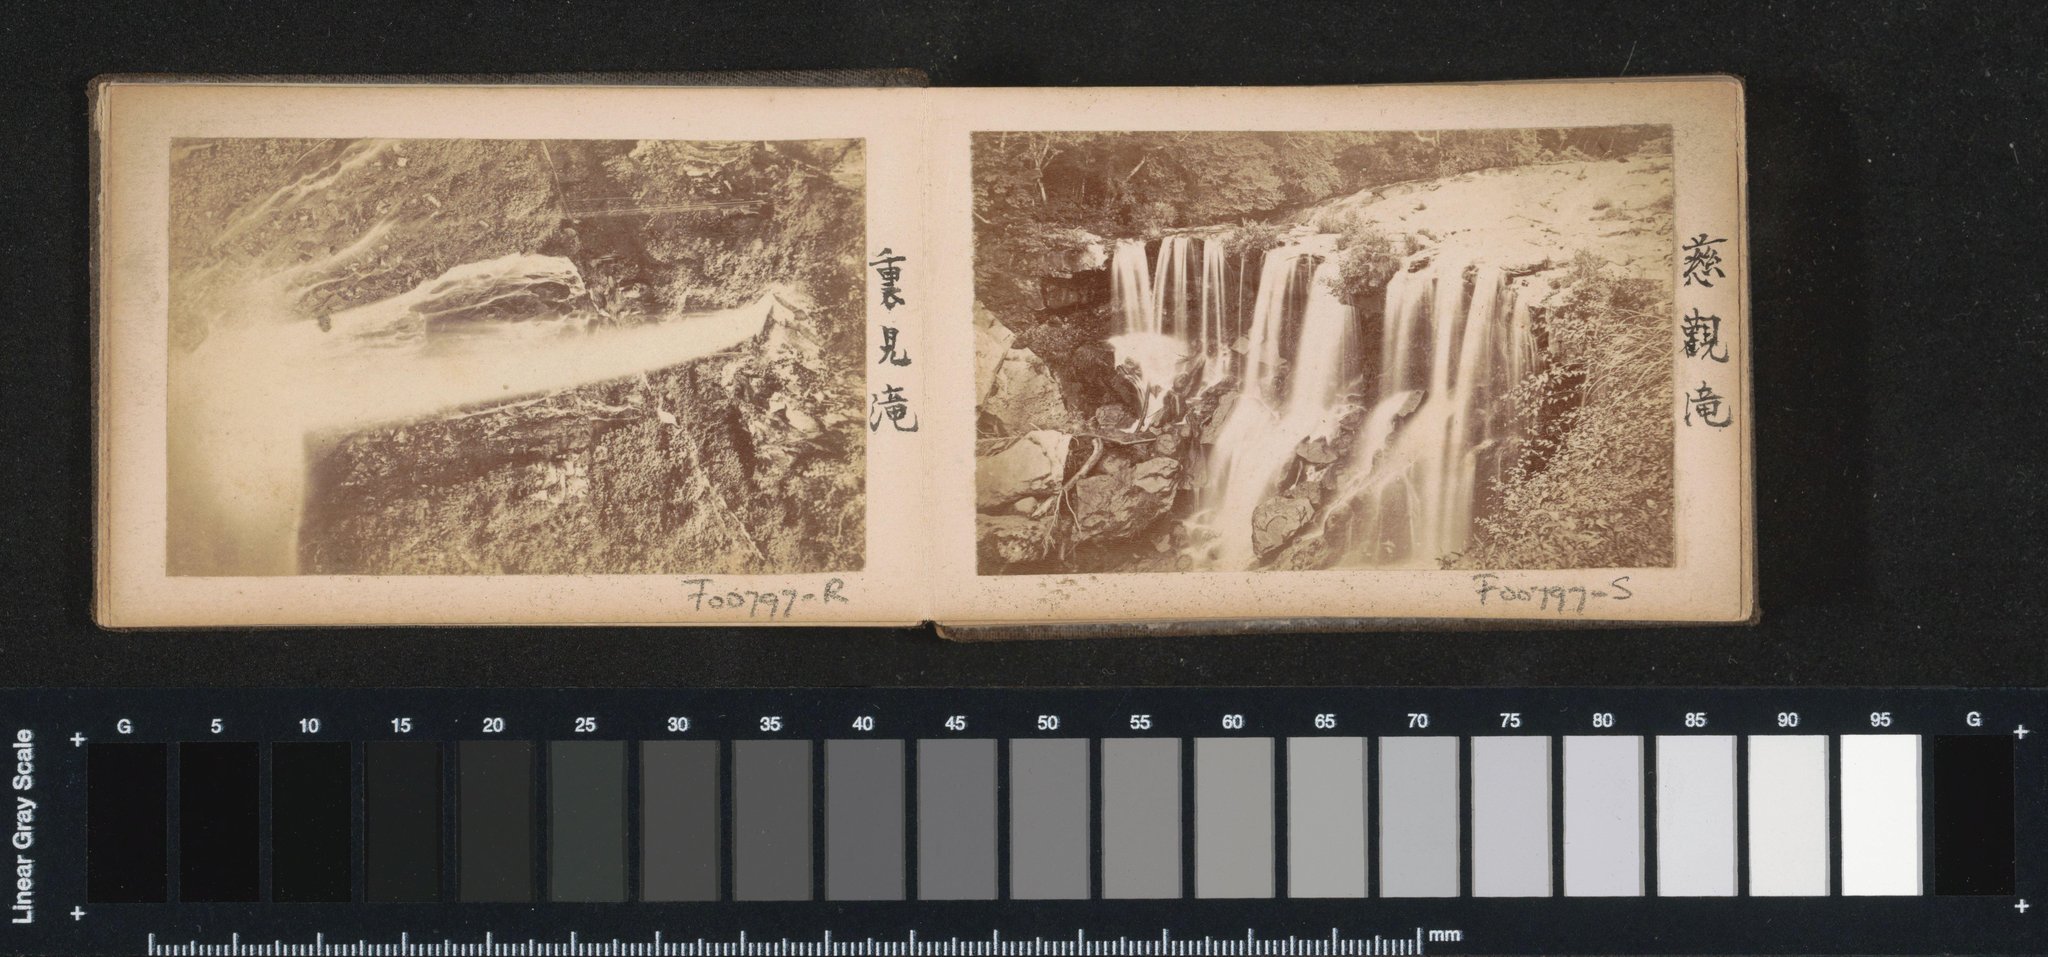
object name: album leaf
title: Waterval in Japan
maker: Anonymous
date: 1870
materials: paper, photographic support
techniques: albumen print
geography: japan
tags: waterfall, japan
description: Onderdeel van Leporelloalbum met 30 foto's van landschappen en gebouwen in Japan.